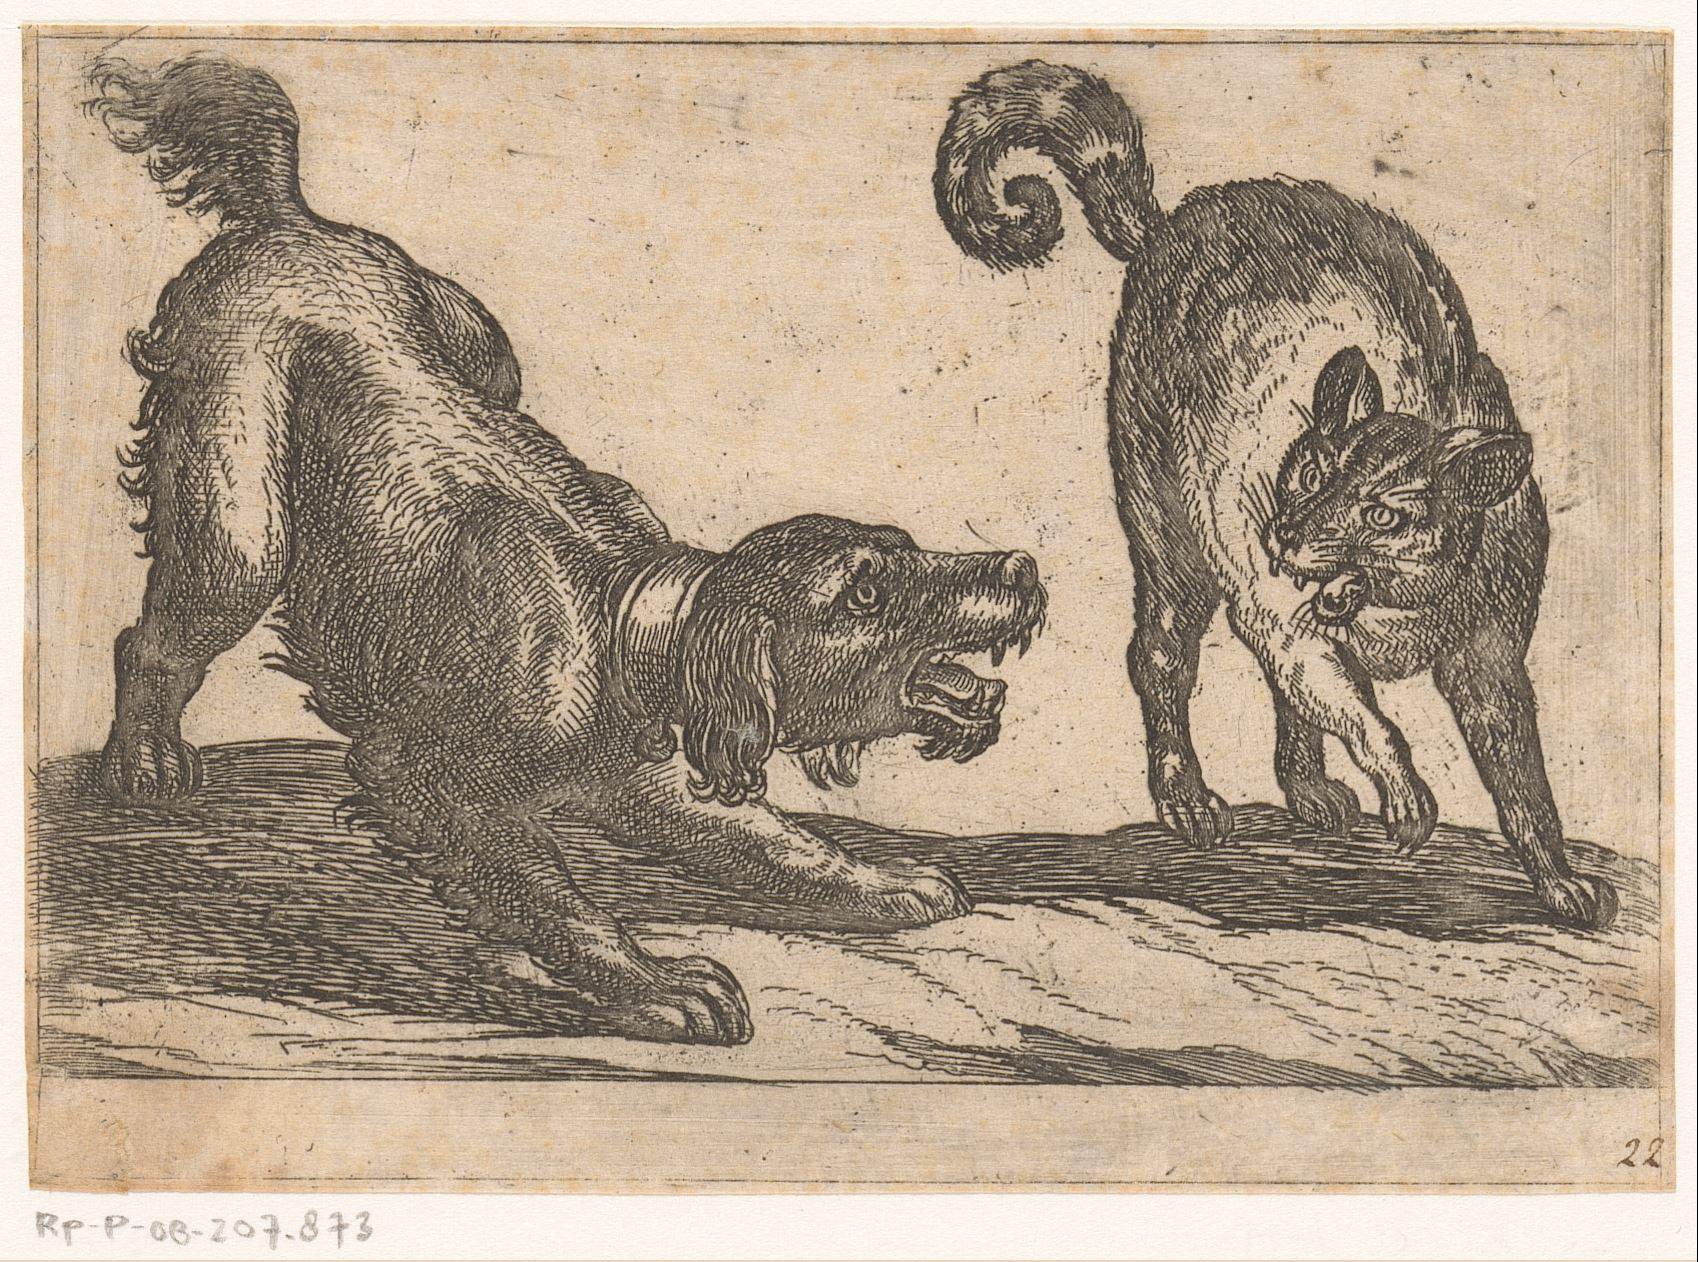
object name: print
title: Vechtende dieren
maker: antonio tempesta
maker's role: draughtsman, painter, print maker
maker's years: 1555-1630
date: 1600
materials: paper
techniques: etching, intaglio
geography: italy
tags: cat, fighting, dog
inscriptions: number: ‘22’, collector's mark: Lugt 2228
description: Deze prent maakt deel uit van een reeks van 25 prenten (+ titelprent) van vechtende dieren.